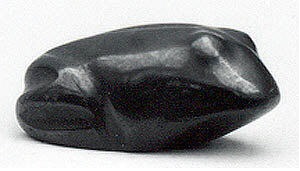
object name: weight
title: Weight in the shape of frog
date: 2000-1668 BCE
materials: mineral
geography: cyprus or western asia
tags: frogs